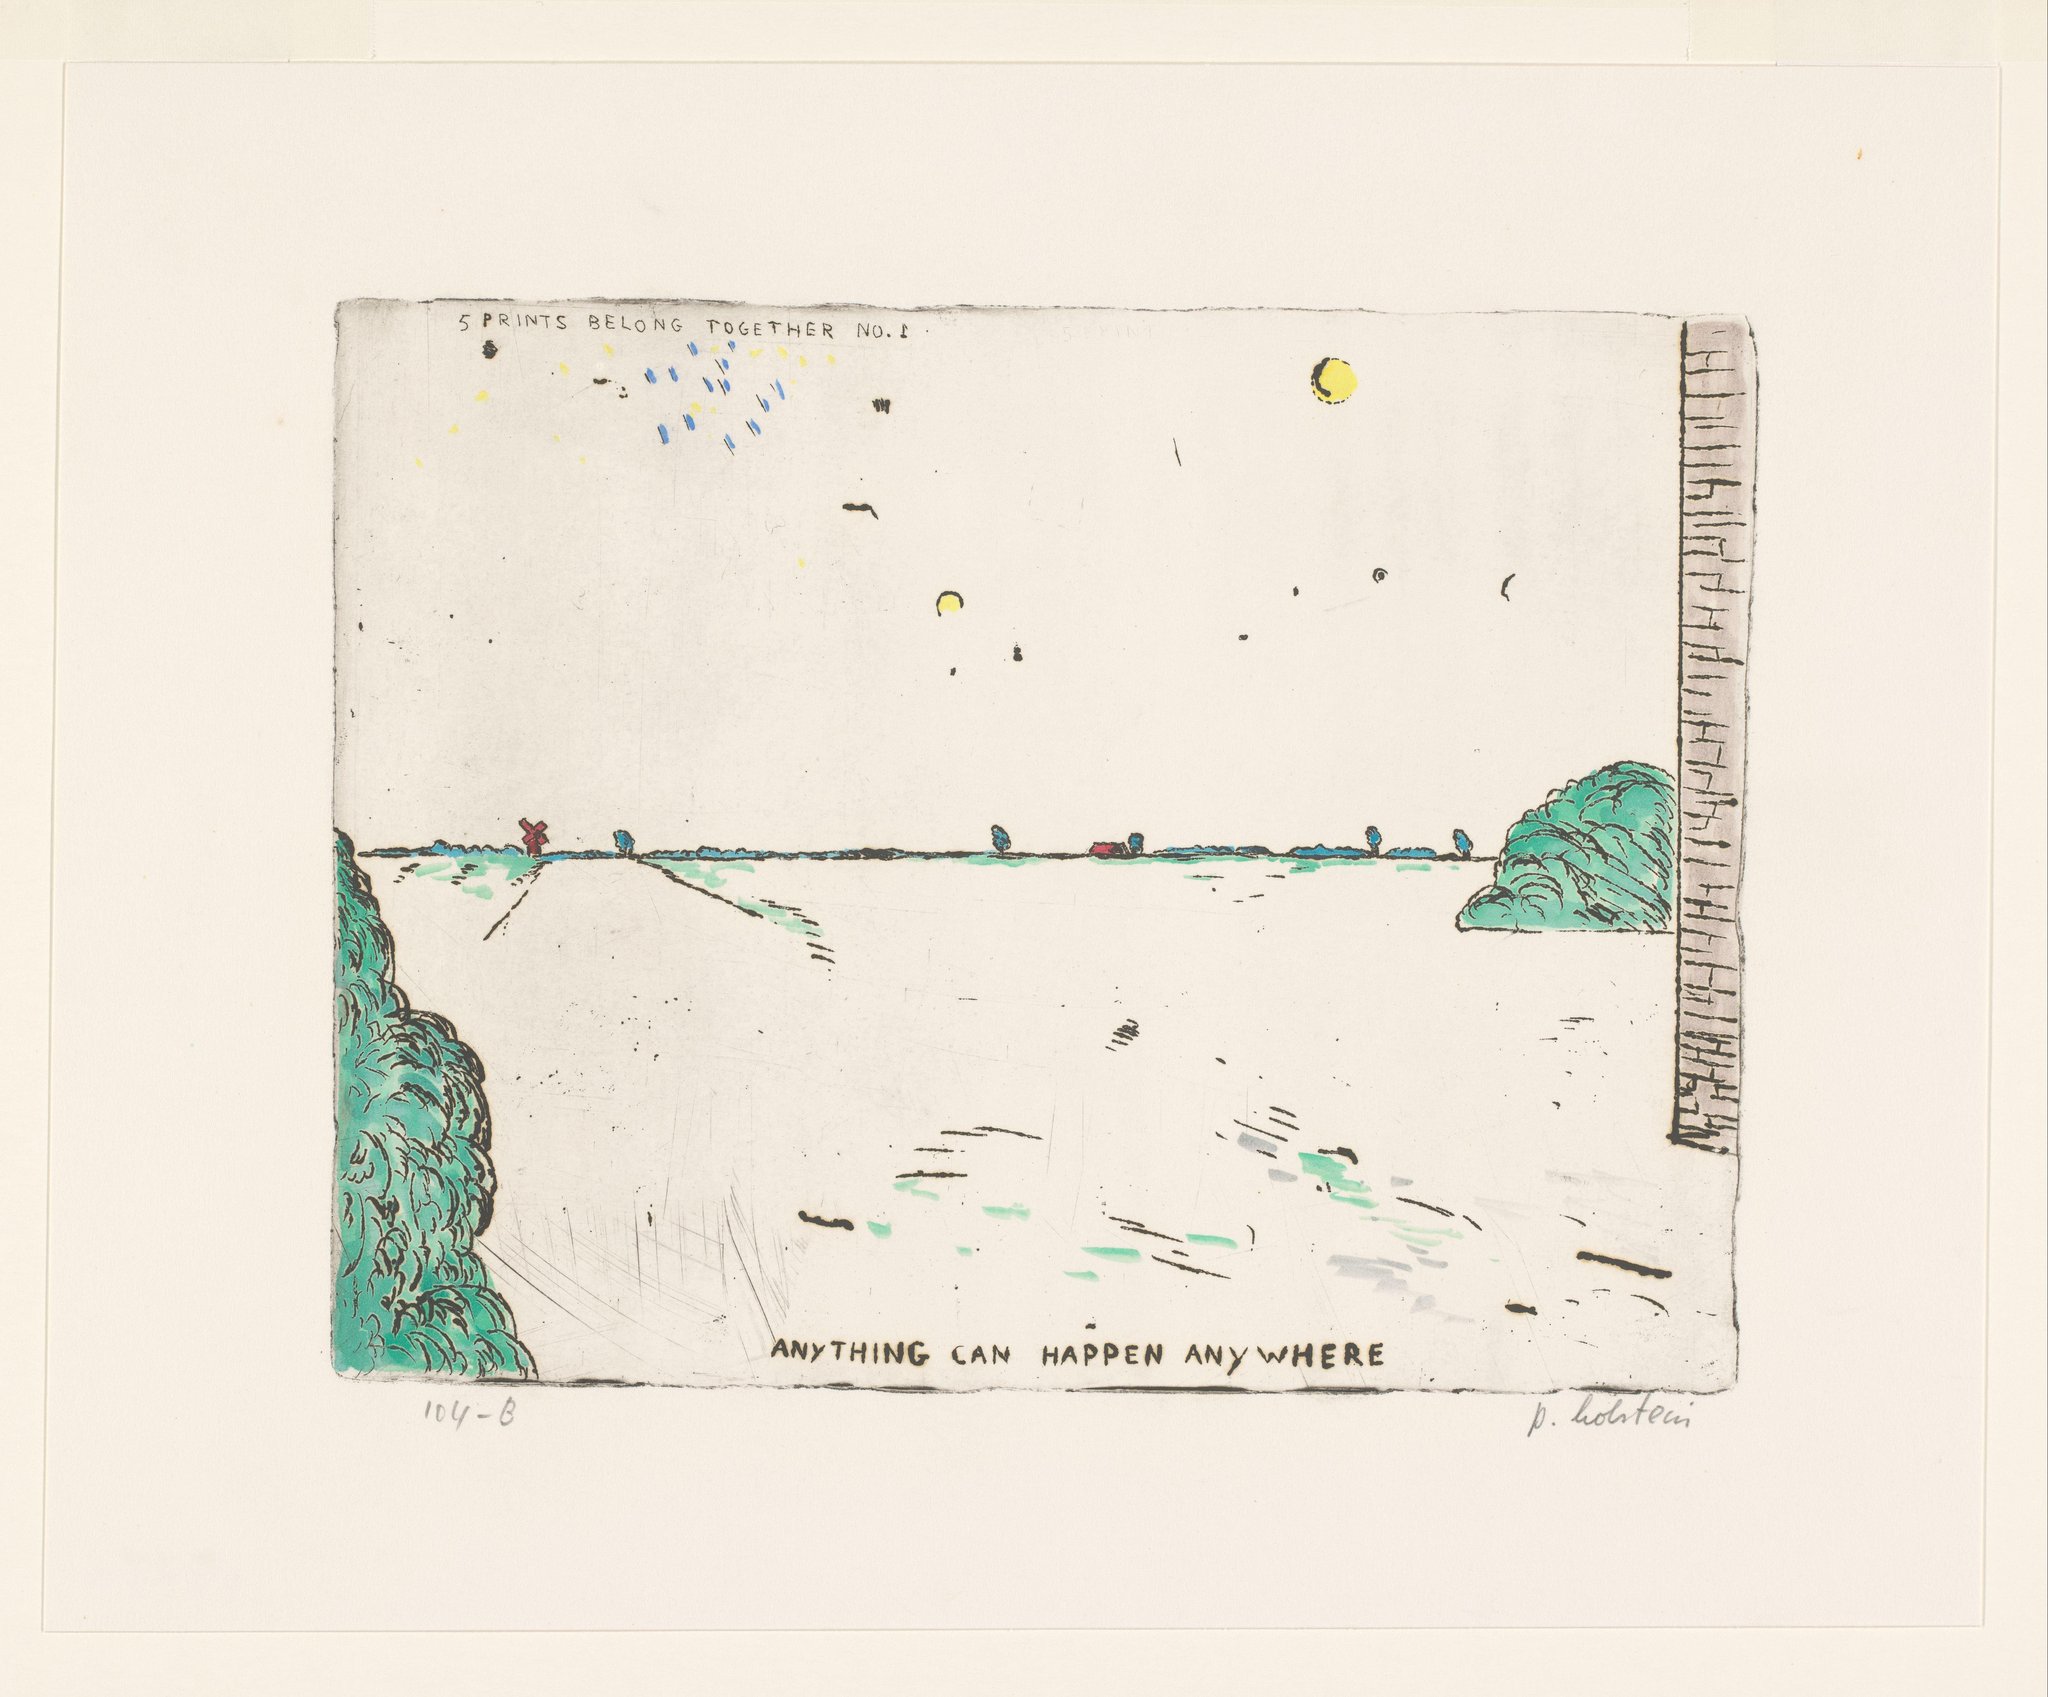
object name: print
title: Anything Can Happen Somewhere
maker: pieter holstein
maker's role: draughtsman, painter, print maker, sculptor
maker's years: 1934-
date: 1970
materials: paper, watercolor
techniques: brush, etching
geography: amsterdam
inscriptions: signature: ‘p. holstein’, title: ‘ANYTHING CAN HAPPEN ANYWHERE’, inscription: ‘104-B’, title: ‘5 PRINTS BELONG TOGETHER NO. 1’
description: Weids vlak landschap met molens aan de horizon, rechts de hoek van een muur.